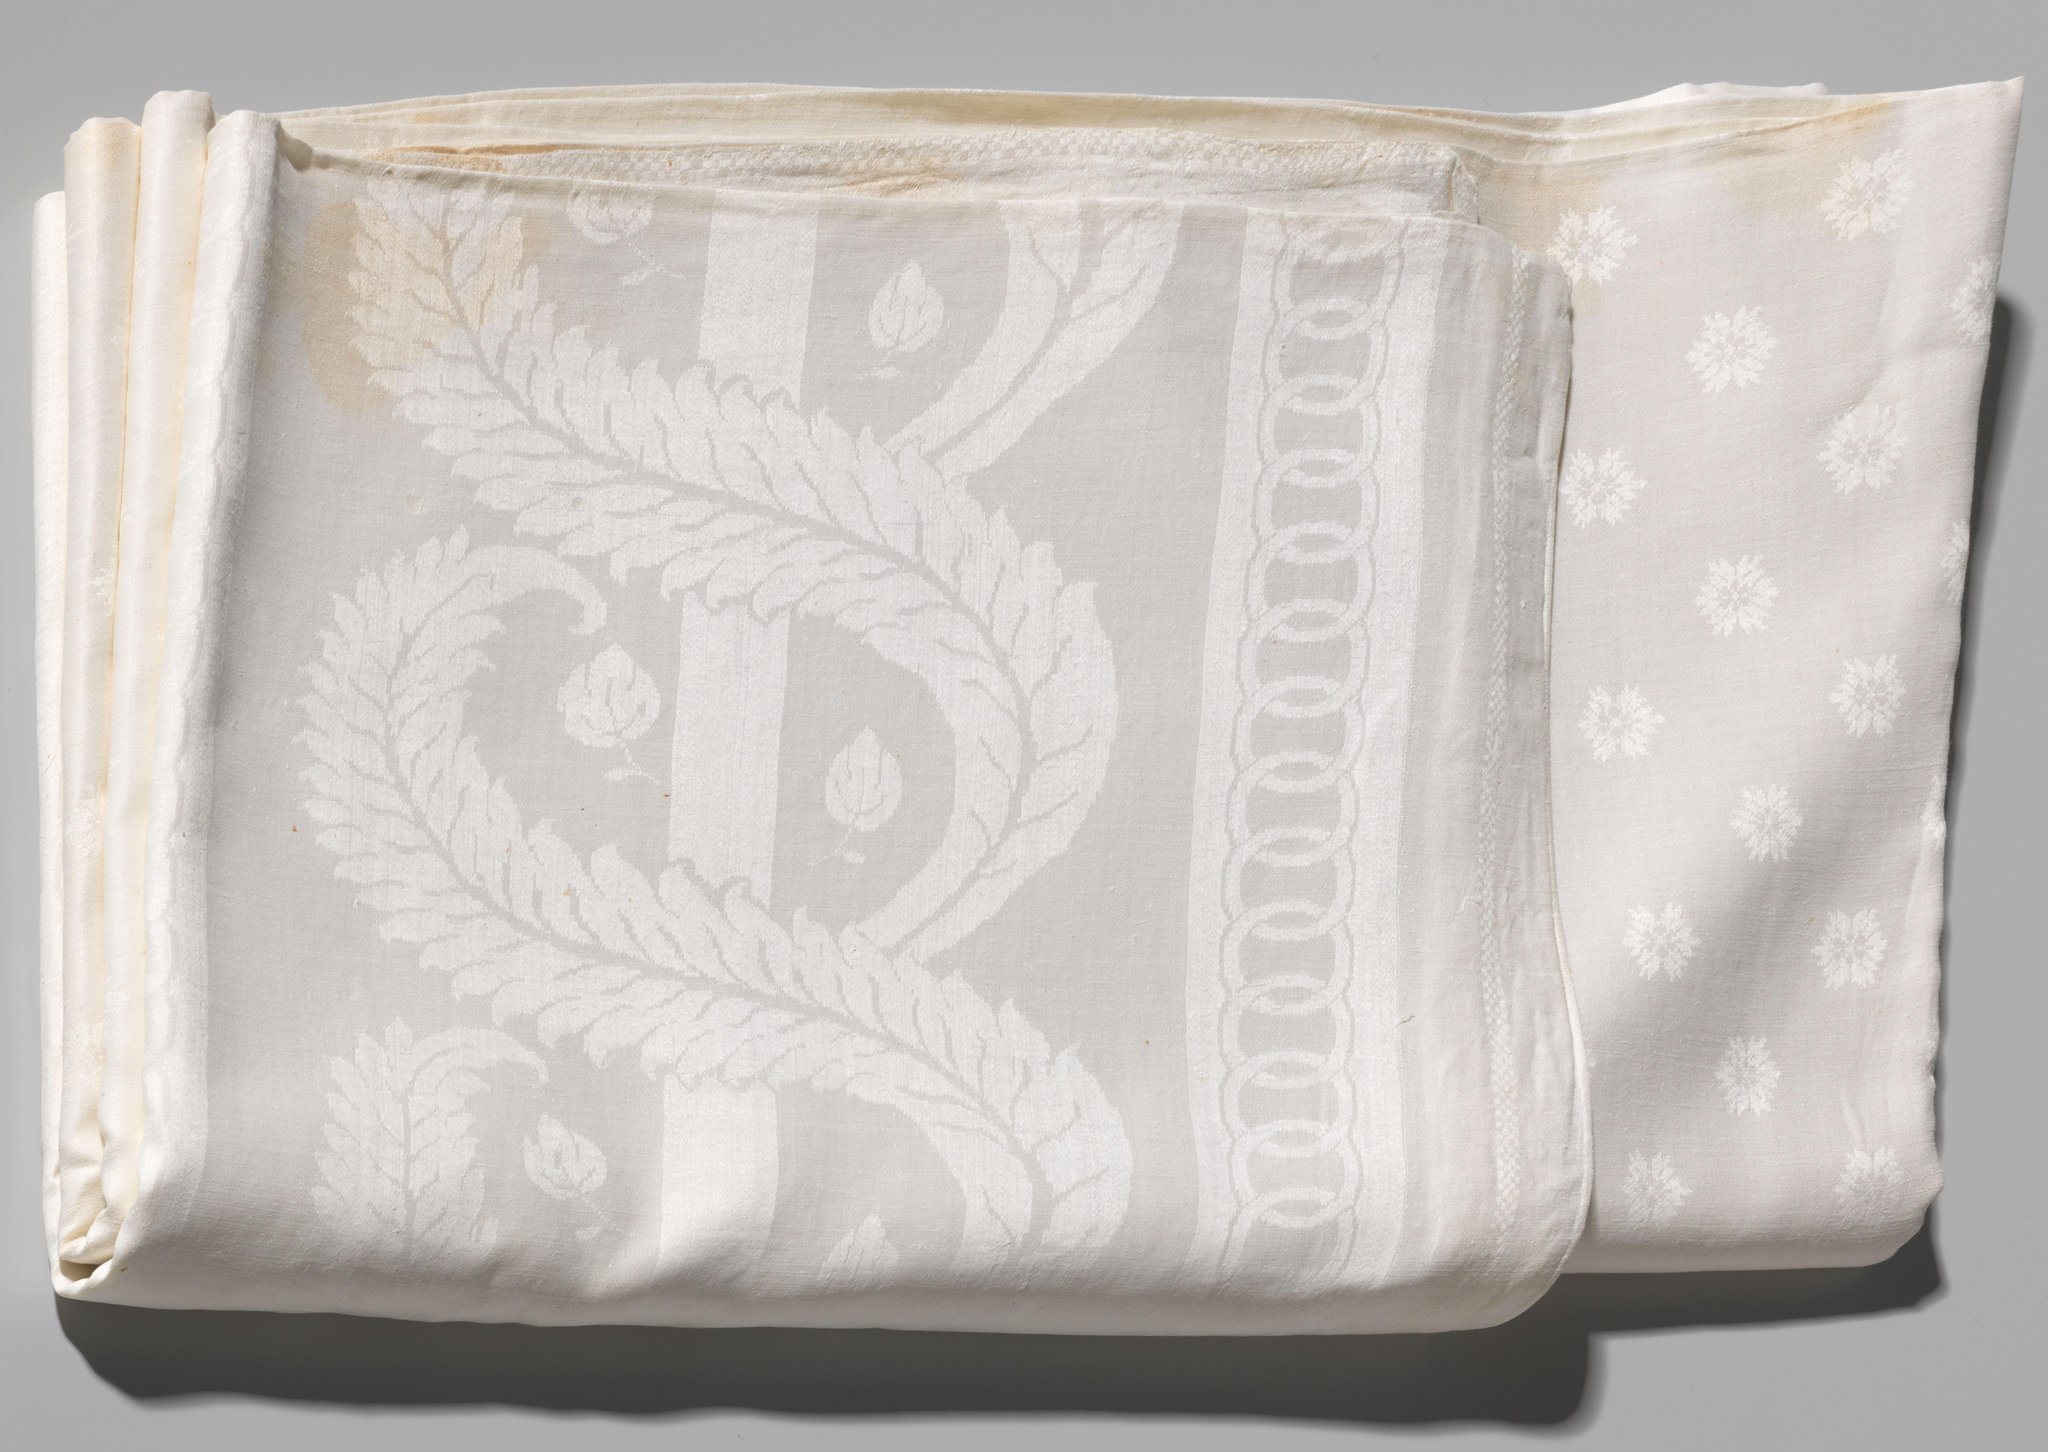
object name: tablecloth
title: Tafellaken met een bloempatroon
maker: Anonymous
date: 1800-1810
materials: linen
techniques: damask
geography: western europe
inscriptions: mark: ‘ME’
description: Tafellaken van linnendamast met een bloempatroon. Verspringende rijen van rozetten. Brede rand van spiraalsgewijs een middenstam omvattende tweezijdig gevederde bladranken. Vallend blaadje als vulling. Gelijke binnen- en buitenzoom van aaneengeschakelde cirkels. Rondom: blokkenrand. De bladranken van de servetten zijn niet identiek aan die van het tafellaken.